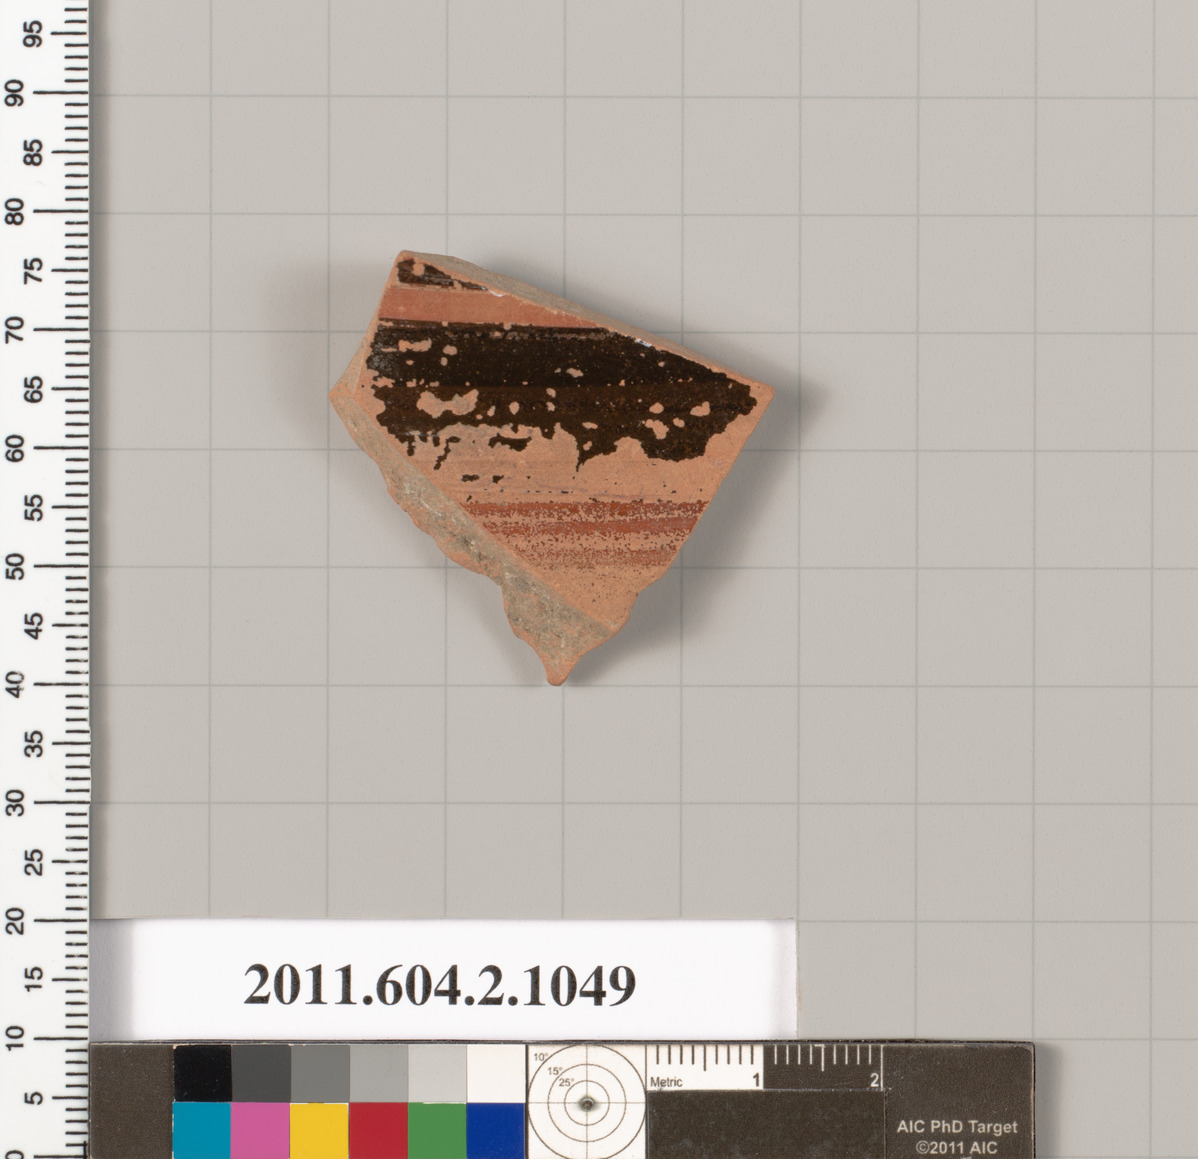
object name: pelike fragment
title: Terracotta fragment of a pelike (jar)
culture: greek, attic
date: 475-440 BCE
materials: terracotta